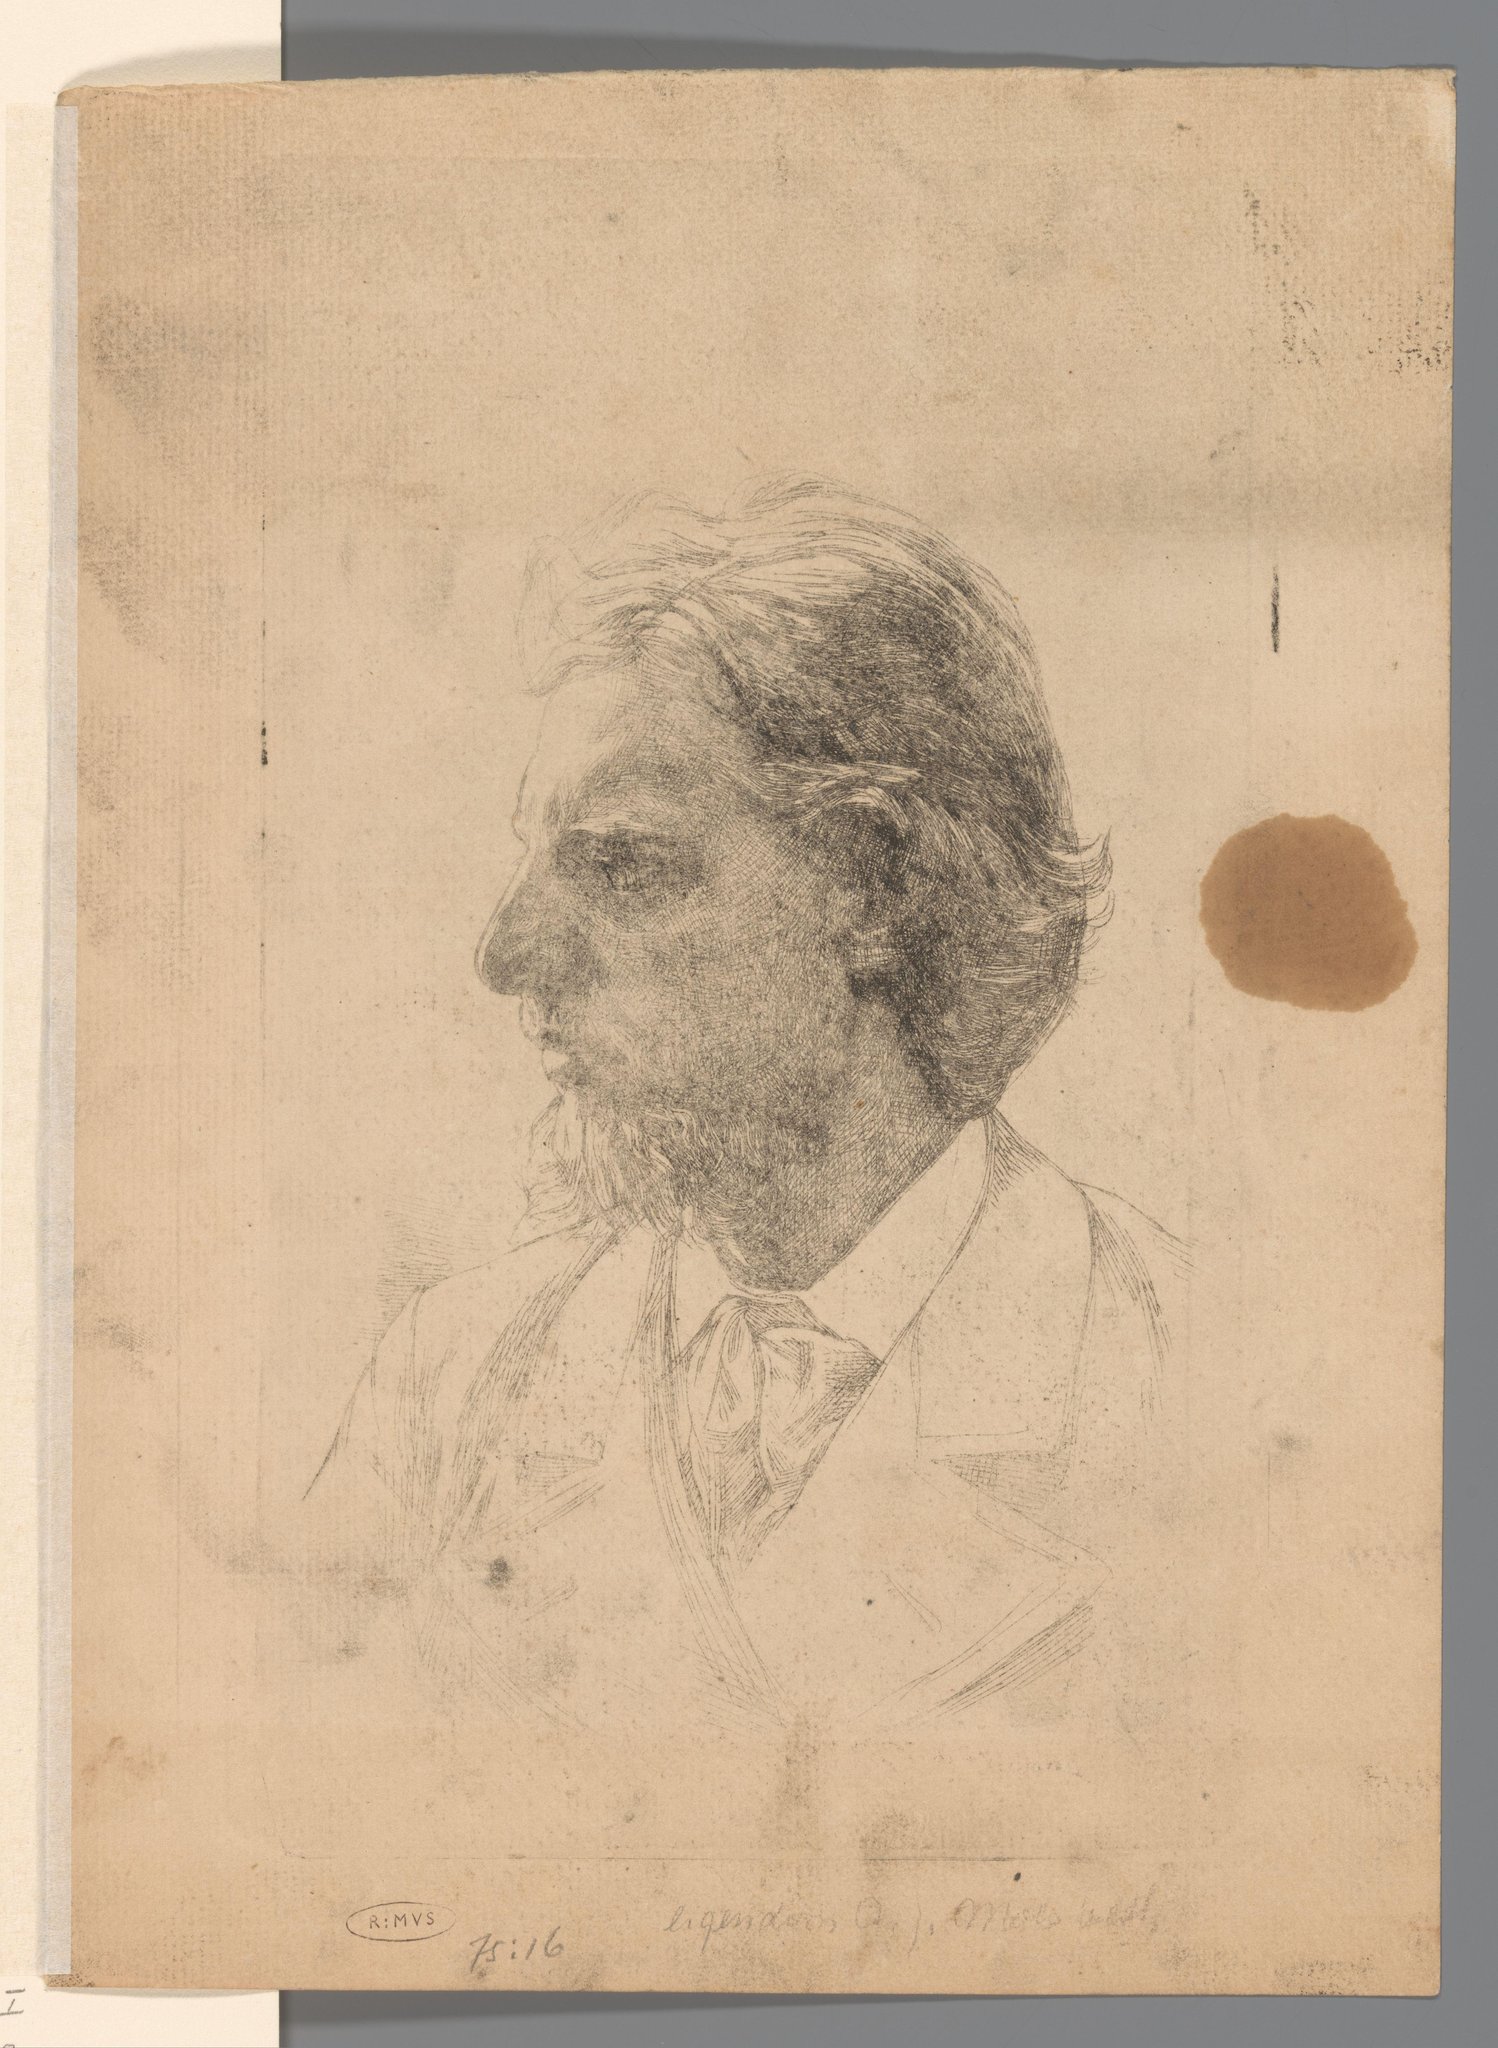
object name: print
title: Portret van Jacques Perk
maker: jan veth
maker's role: designer, draughtsman, painter, print maker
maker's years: 1864-1925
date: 1887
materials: paper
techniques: etching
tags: jacques perk, historical persons, writer, poet, author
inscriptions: collector's mark: Lugt 2228